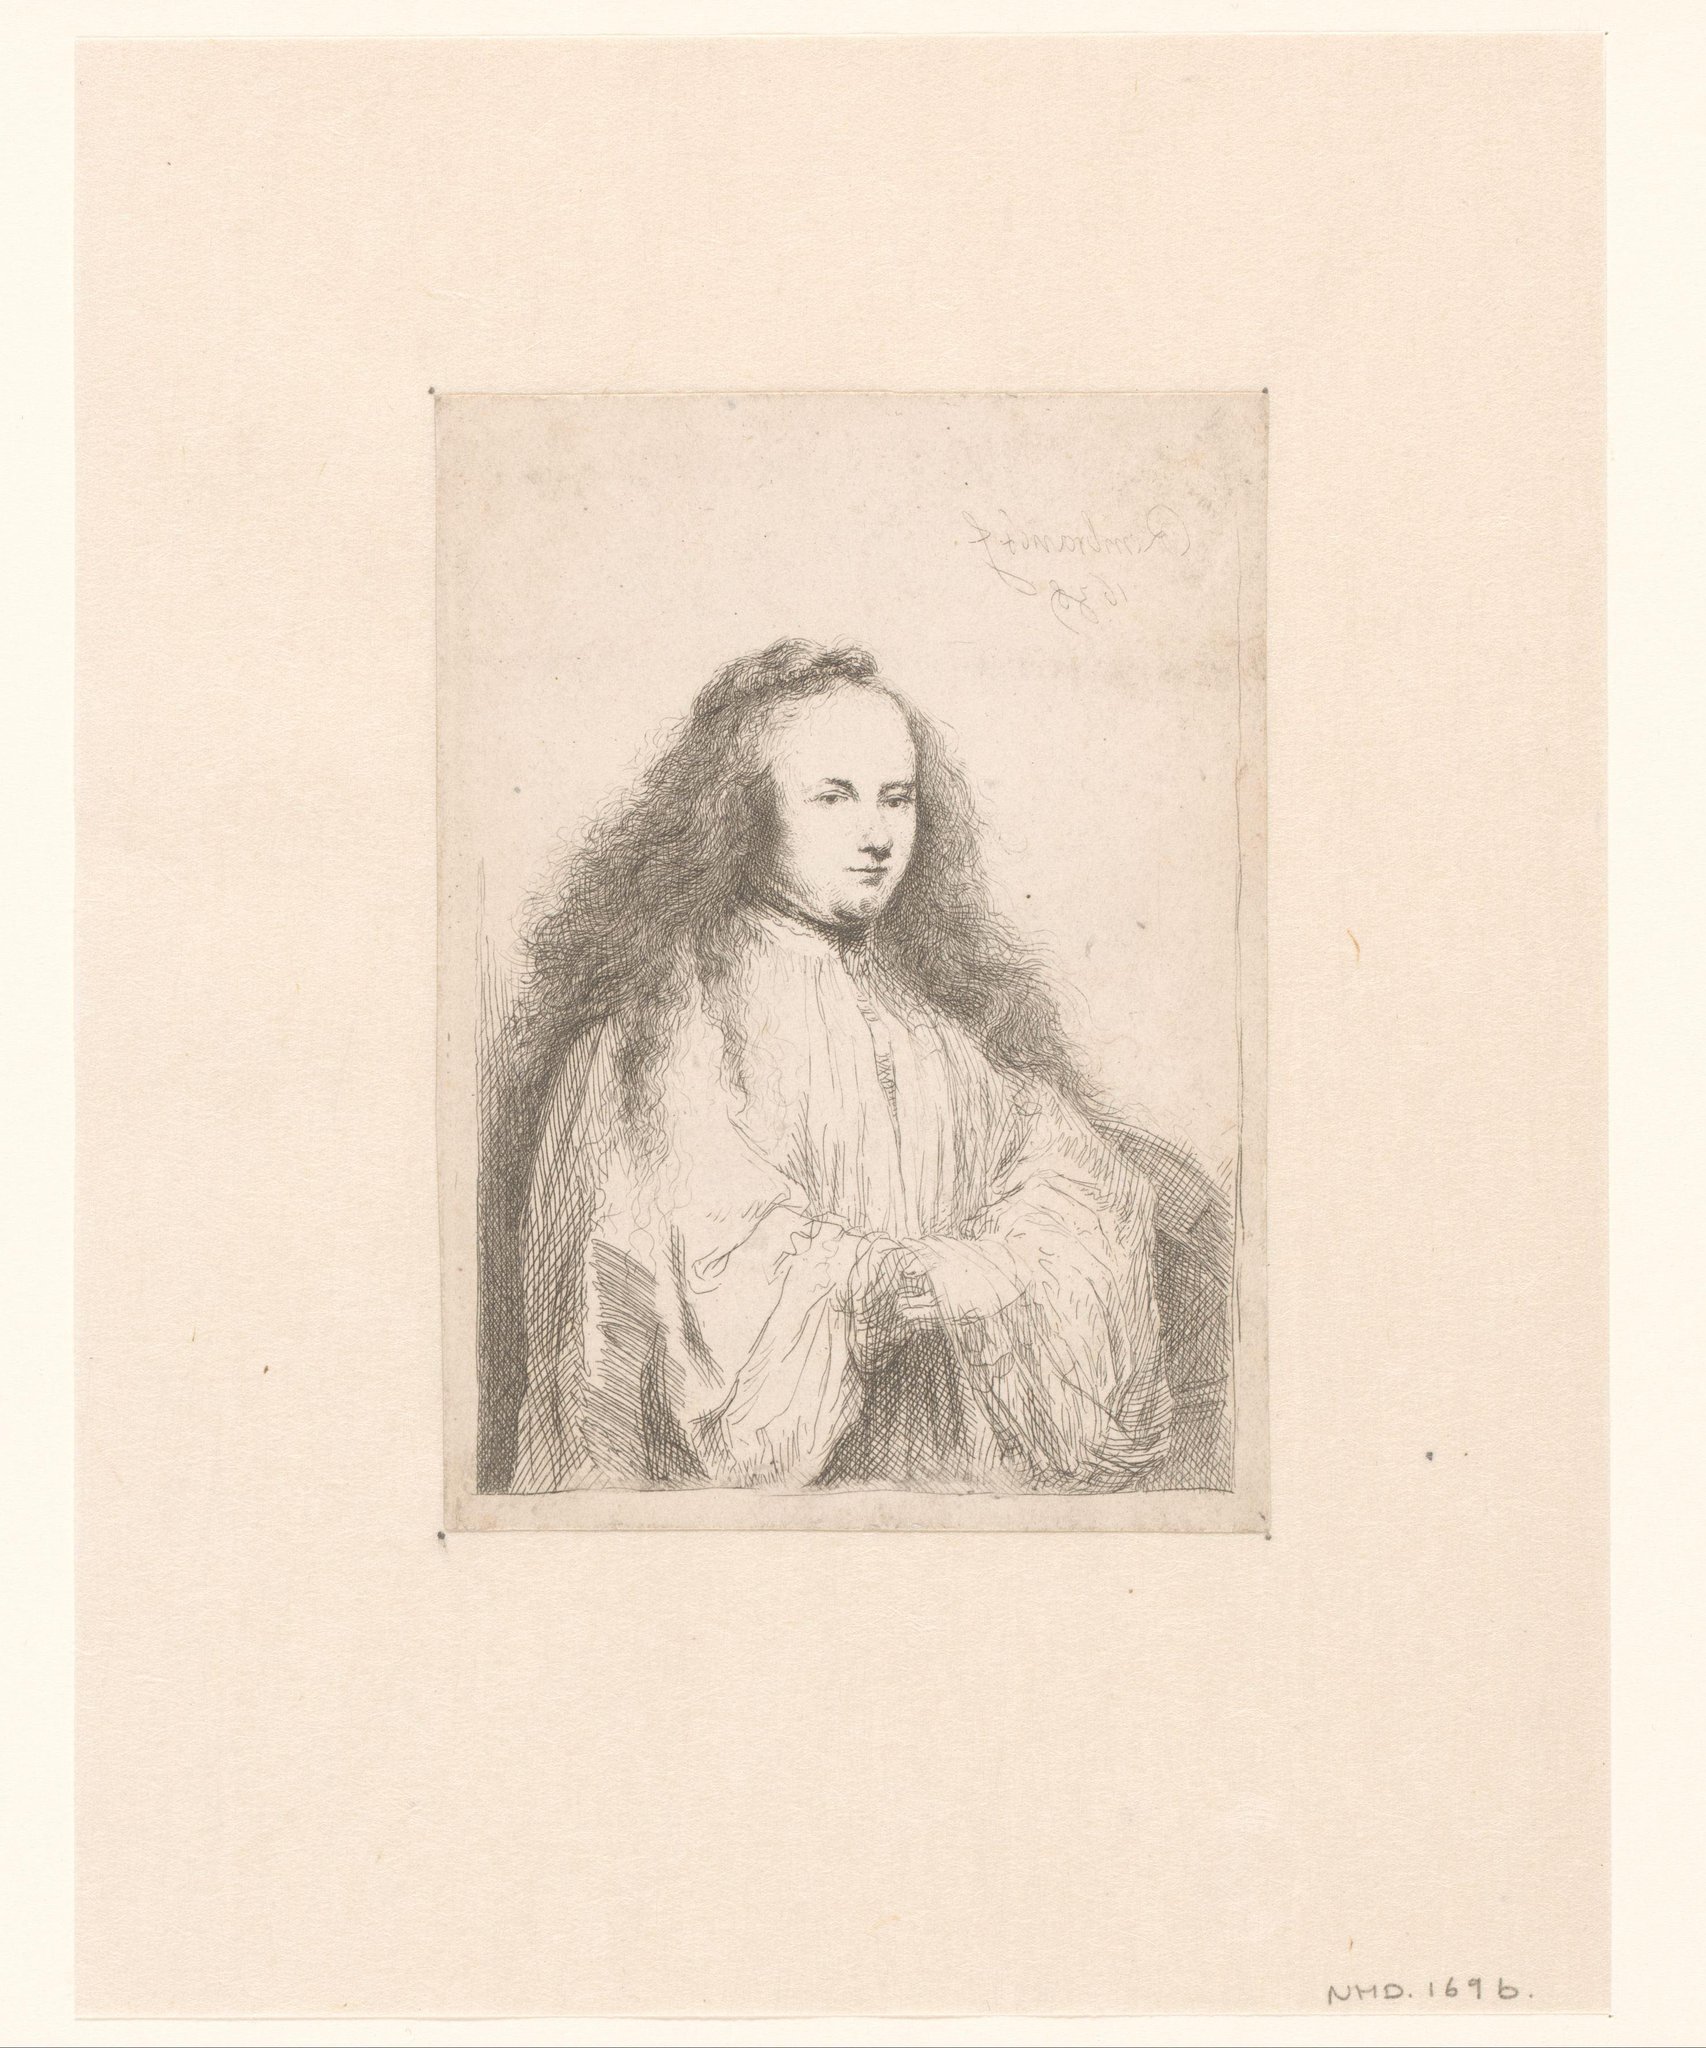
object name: print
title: St Catherine ('the little Jewish bride')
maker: ignace-joseph de claussin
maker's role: print maker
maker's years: 1766-1844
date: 1816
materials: paper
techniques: etching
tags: amsterdam, the virgin martyr catherine of alexandria; possible attributes: book, crown, emperor maxentius, palm-branch, ring, sword, wheel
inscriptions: collector's mark: Lugt 556c, collector's mark: Lugt 2760, collector's mark: Lugt 2228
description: Prent gebruikt in: A collection of 200 original etchings. Londen: J.M. Creery, [1816].